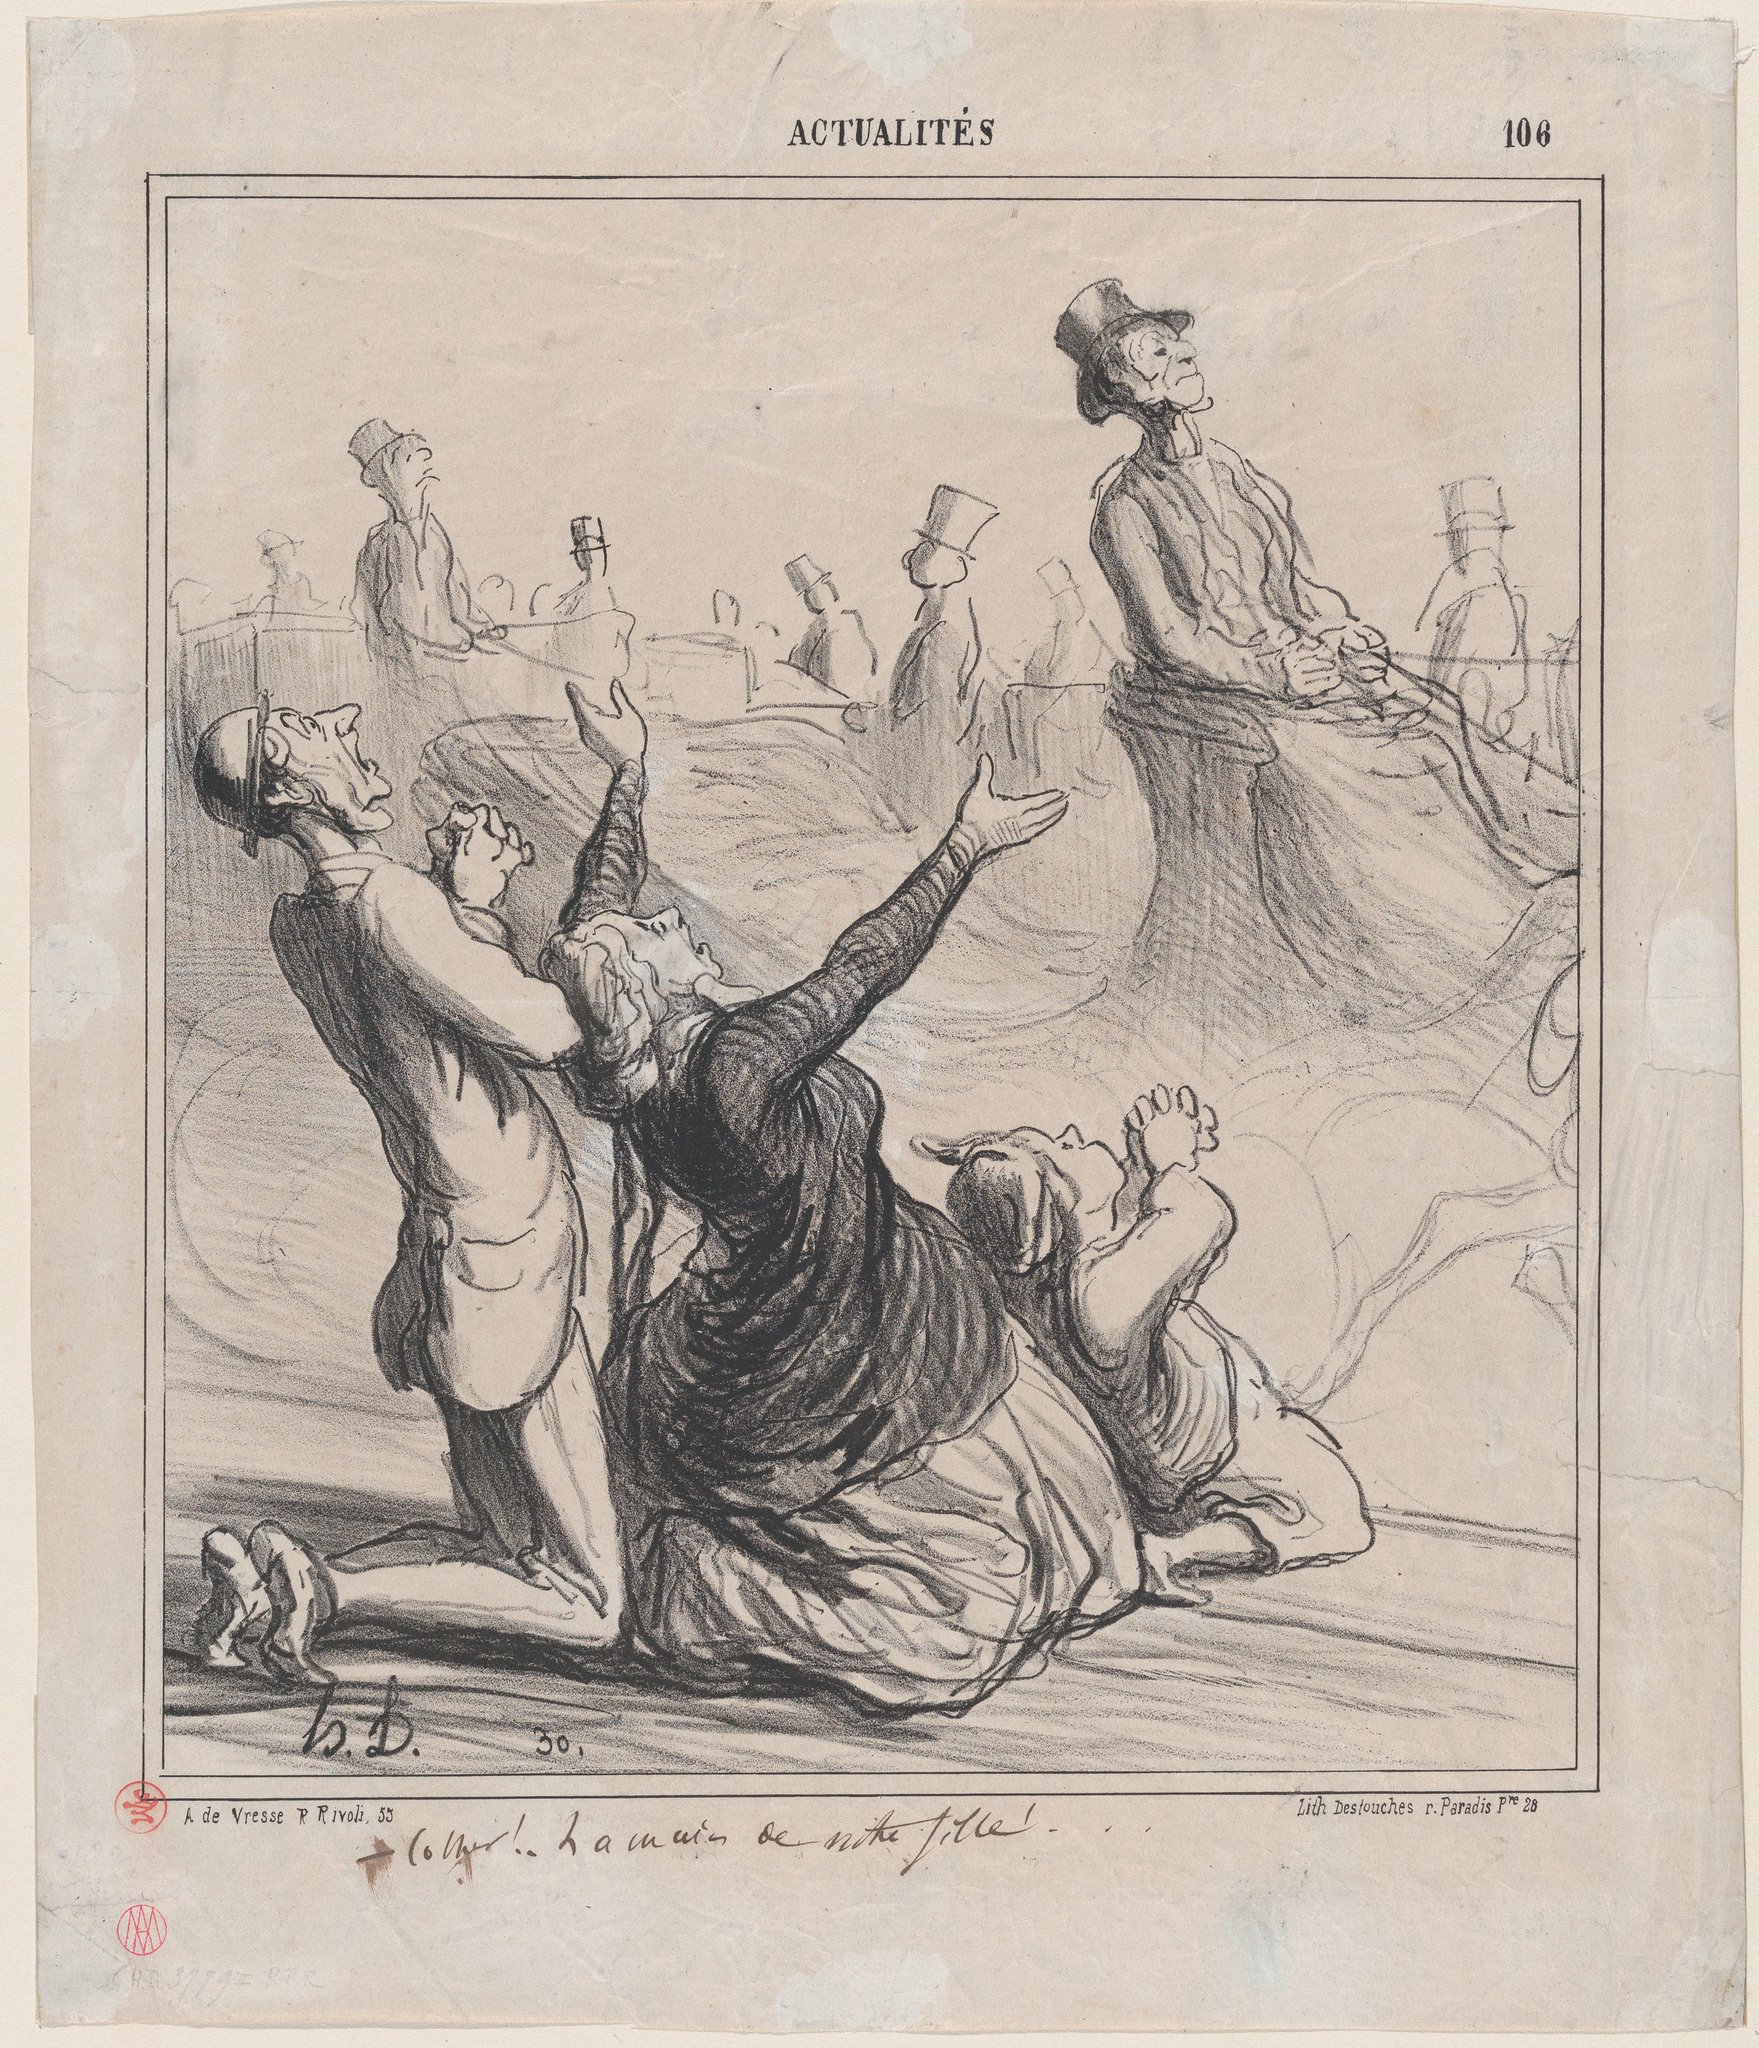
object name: print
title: Coachman, for the hand of our daughter!..., from 'News of the day,' published in "Le Charivari"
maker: honoré daumier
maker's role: artist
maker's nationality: french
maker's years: 1808-1879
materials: ink, paper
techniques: lithograph, pen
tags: satire,men,women,carriages